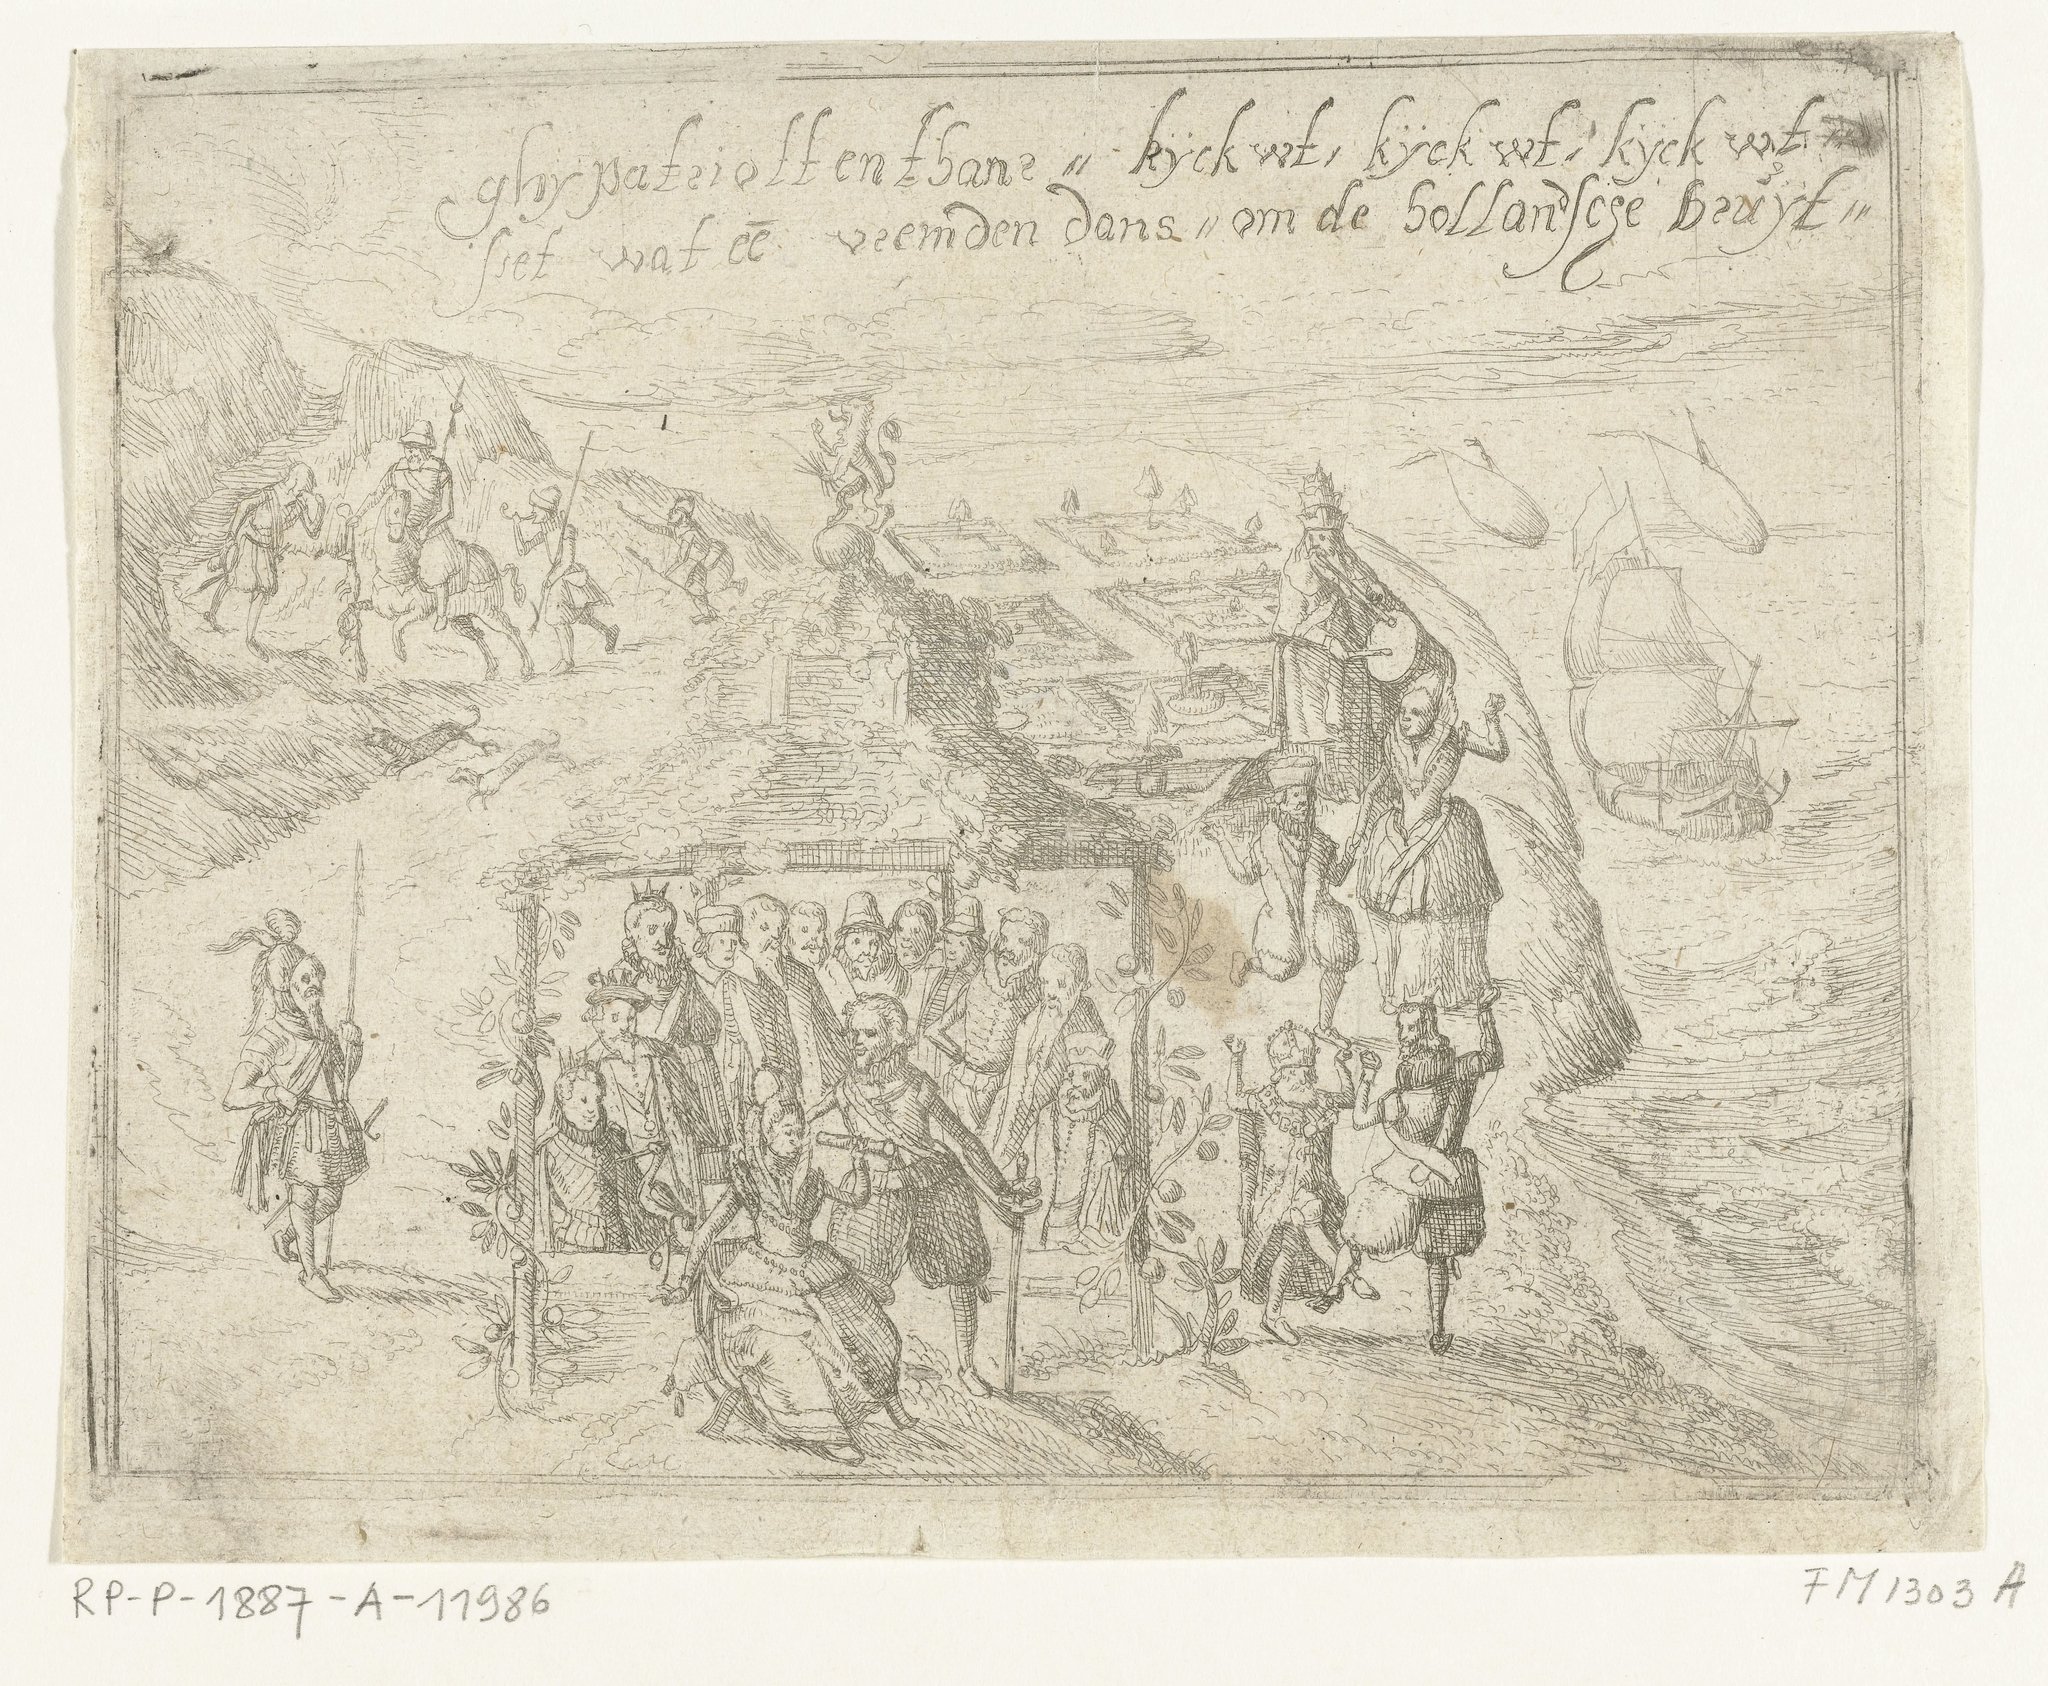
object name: print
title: ghy patriotten thans "kyck wt, kyck wt, kyck wt, siet wat ee[n] vremden dans" om de hollandsche bruyt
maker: Anonymous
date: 1615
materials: paper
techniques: etching, letterpress printing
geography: low countries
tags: the hague, maurice (prince of orange), infante van spanje isabella clara eugenia, brussels, albrecht aartshertog van oostenrijk, dancing, personifications of countries, nations, states, districts, etc., telescope, netherlands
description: Titelprent van het pamflet getiteld: Ghy Patriotten thans "kijck uut, kijck uut, Siet wat een vreemden Dans" om de Hollandtsche Bruut. De Hollandse Maagd zittend onder een prieel bekroond met de Hollandse Leeuw met verrekijker en een kraanvogel in de hand, achter haar staat prins Maurits voor een groep van vorsten. Rechts dansen de keizer, de koning van Spanje, aartshertog Albrecht en Isabella waarbij de paus op trom en fluit de maat aangeeft. Op de achtergrond een man te paard, een tuin en een kustlandschap met schepen op zee. Gevoegd bij de prent de laatste pagina (nr. 11) uit het pamflet, op beide zijden bedrukt.